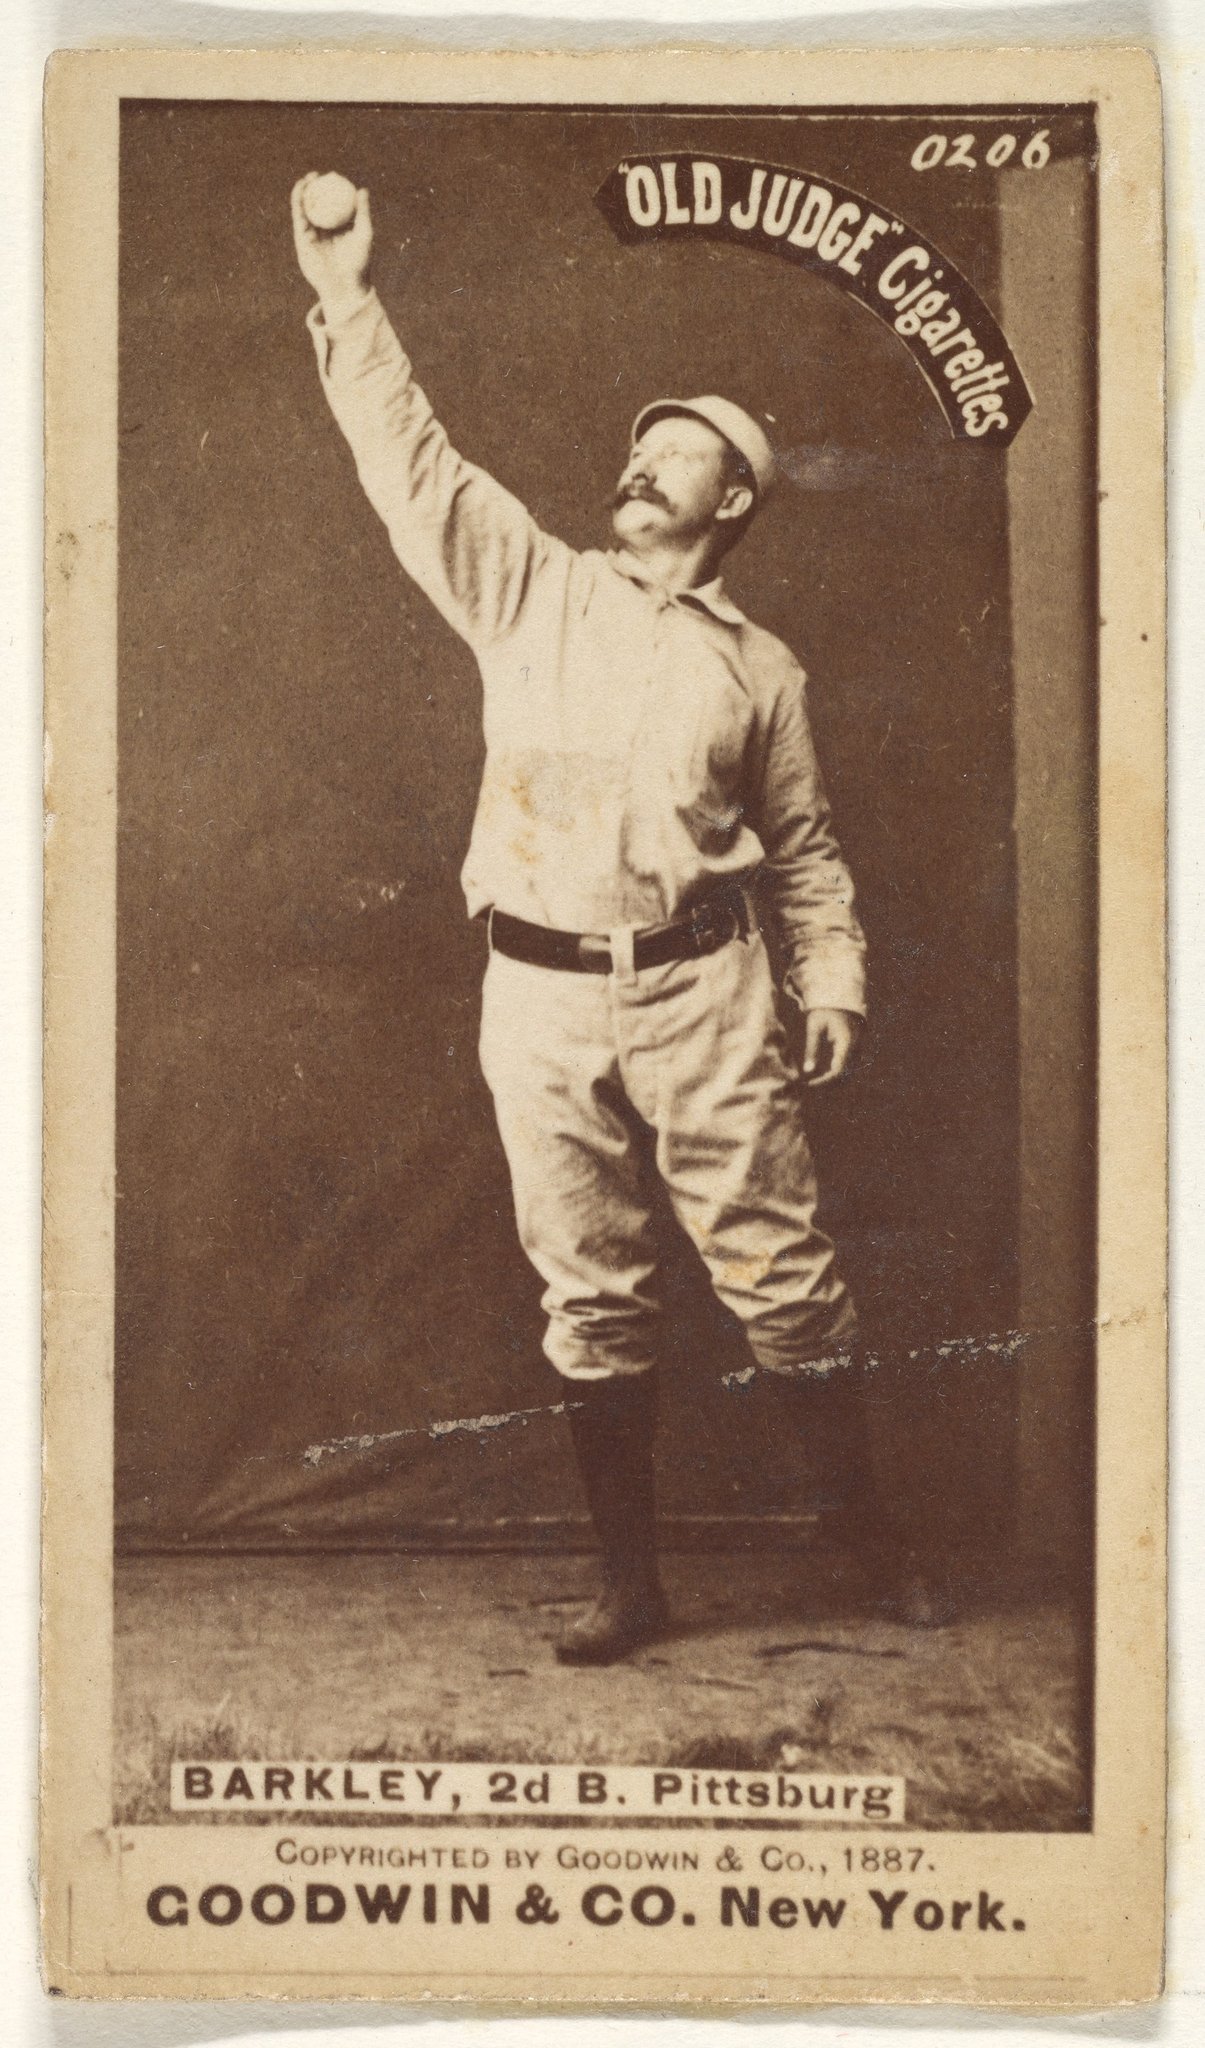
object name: baseball card, photograph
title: Sam Barkley, 2nd Base, Pittsburgh, from the Old Judge series (N172) for Old Judge Cigarettes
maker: goodwin & company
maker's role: publisher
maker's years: 1850-1950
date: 1887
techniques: albumen silver print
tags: men,portraits,baseball,athletes